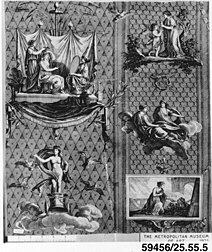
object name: piece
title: Marie Stuart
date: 1815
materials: linen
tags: children,women,female nudes,dressing